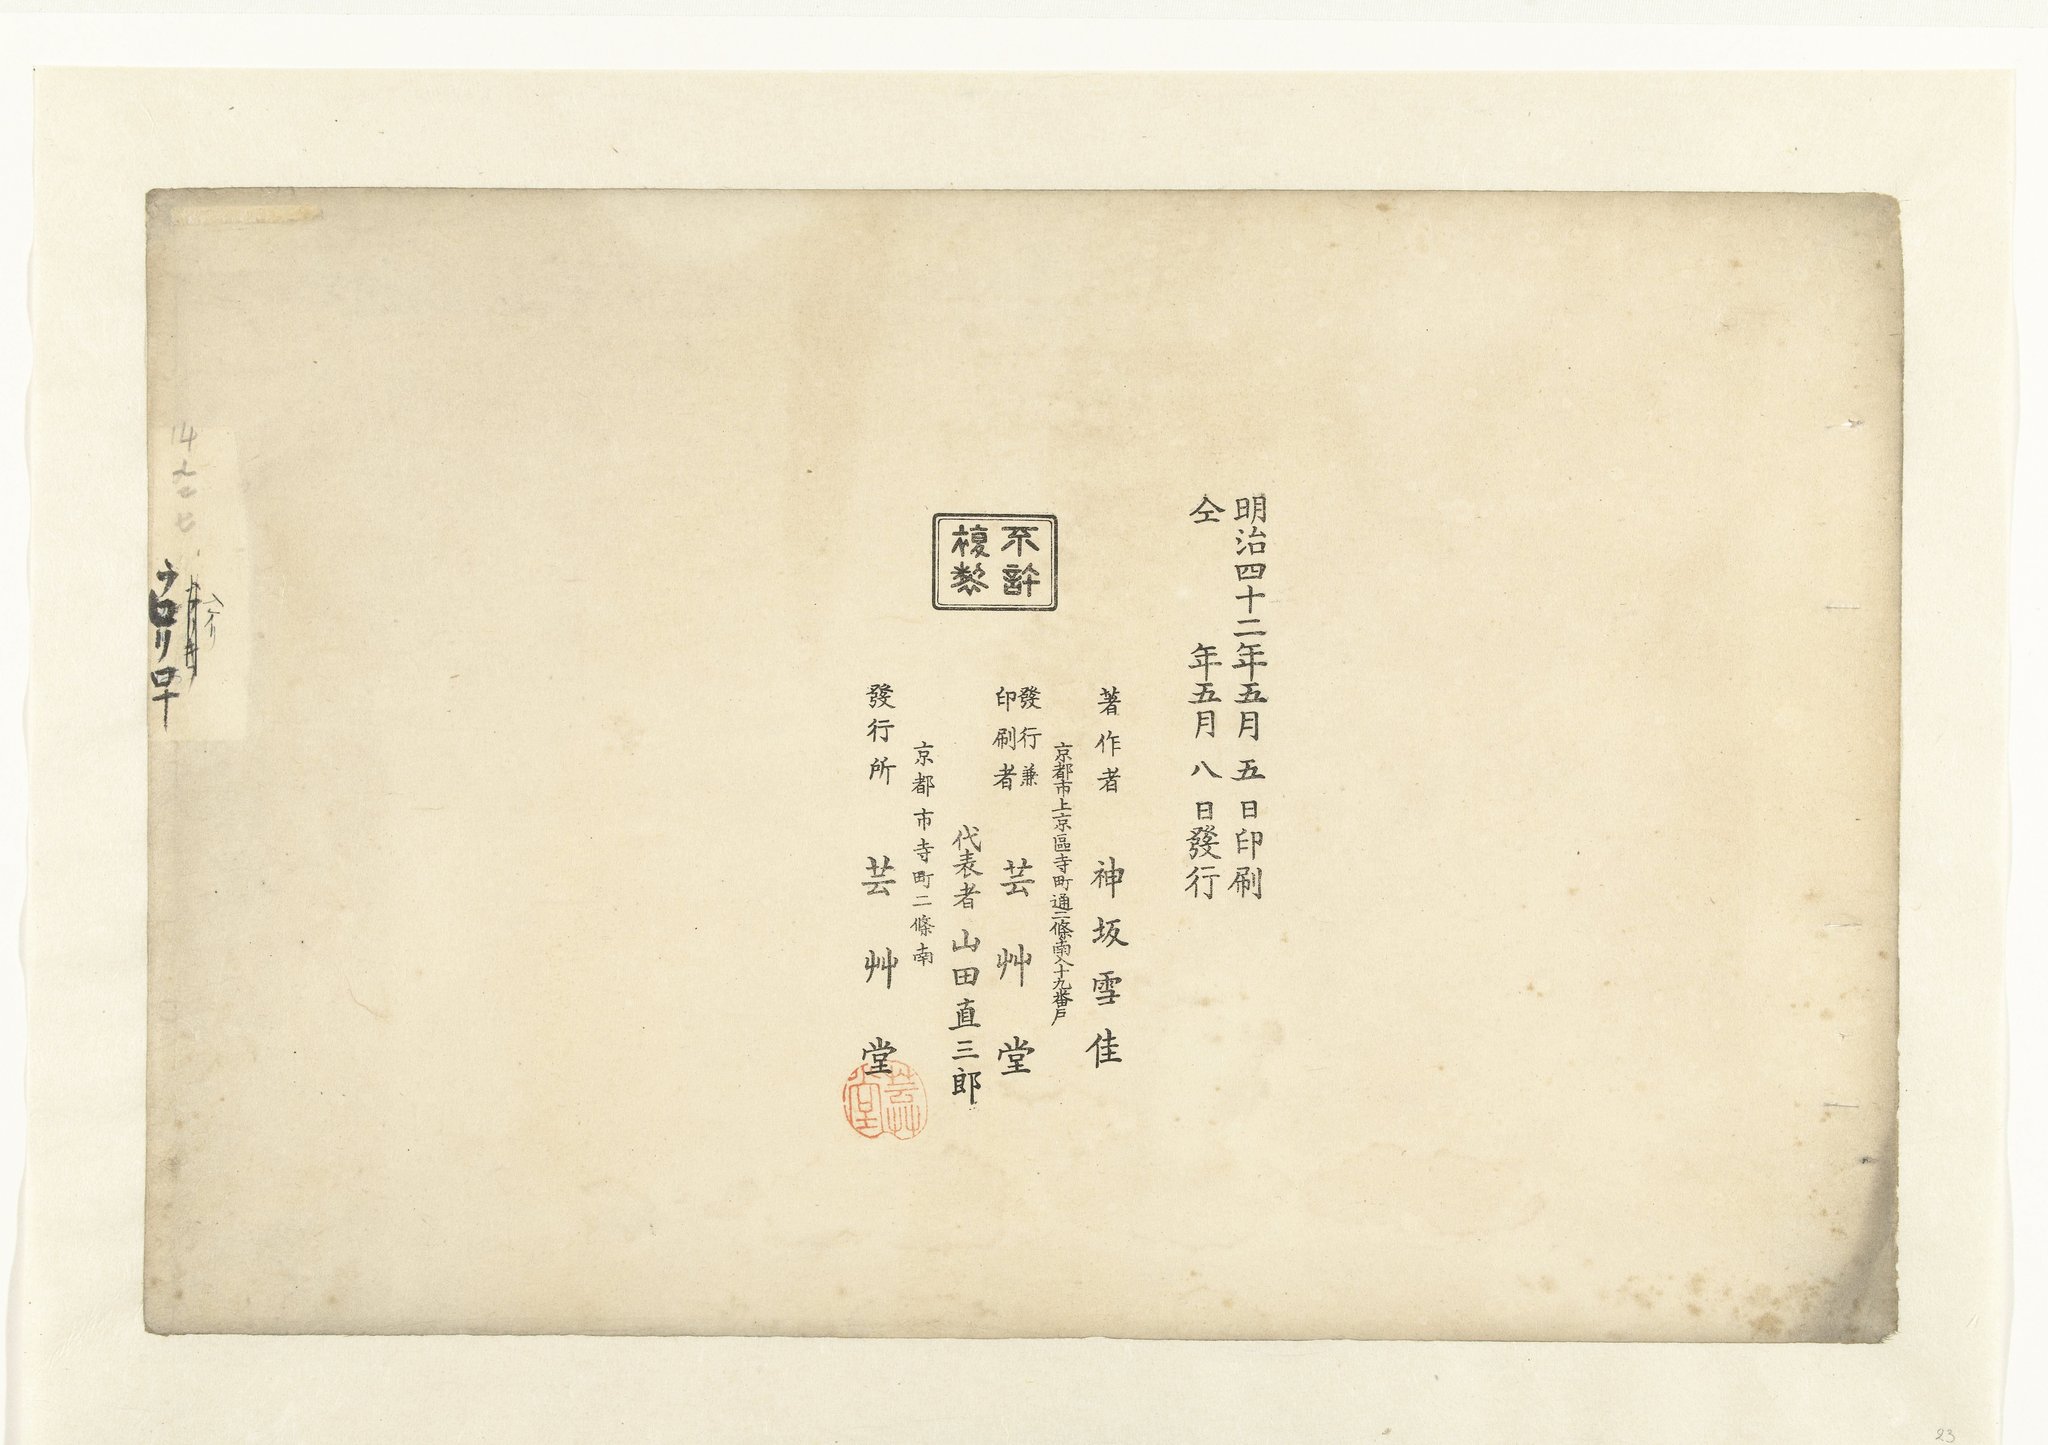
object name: print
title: Colofon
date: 1909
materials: paper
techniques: woodcut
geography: kyoto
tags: writing and letters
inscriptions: collector's mark: Lugt 2228, collector's mark: Lugt 2760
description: Colofon van deel 1 van het album Momoyogusa. Midden: Kamisaka Sekka, Unsodo. Midden onder: Uitgeverszegel Unsodo. Midden rechts: Meiji 42, vijfde maand, vijfde dag (1909-05-05). Het colofon volgt op de laatste van de 20 prenten.